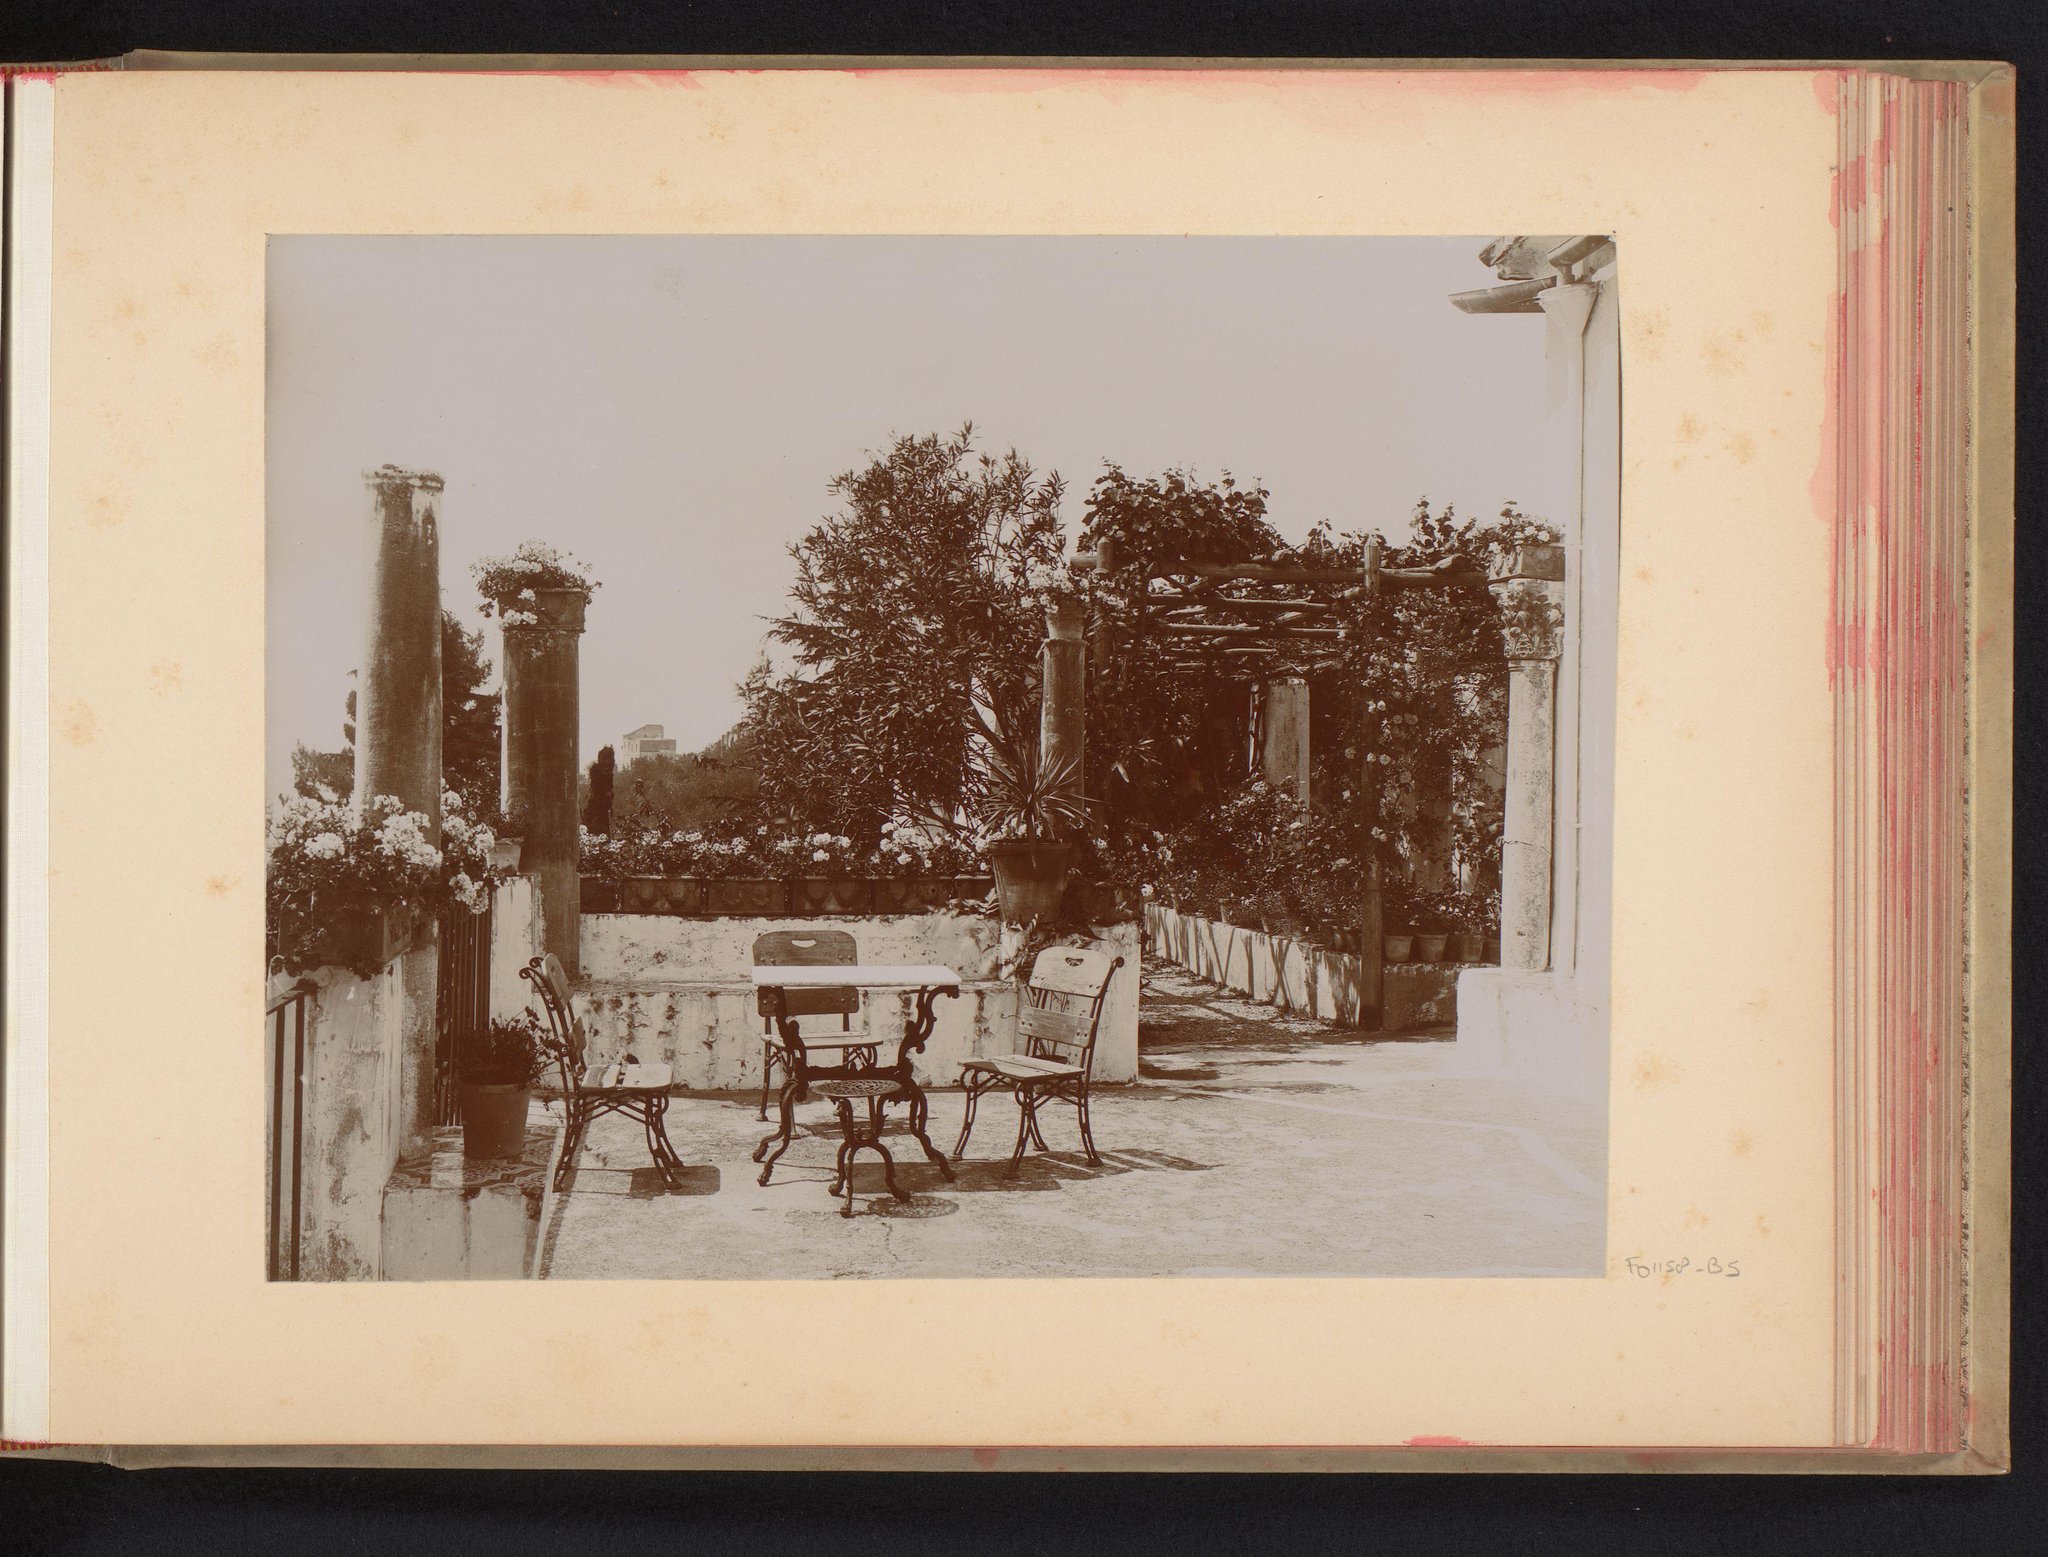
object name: photograph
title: Balkon (vermoedelijk) te Italië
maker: Anonymous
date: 1875-1907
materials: photographic support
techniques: gelatin silver print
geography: italy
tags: column, pillar ~ architecture, loggia, verandah, porch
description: Onderdeel van Fotoalbum met opnames van bezienswaardigheden en kunstwerken in Italië.